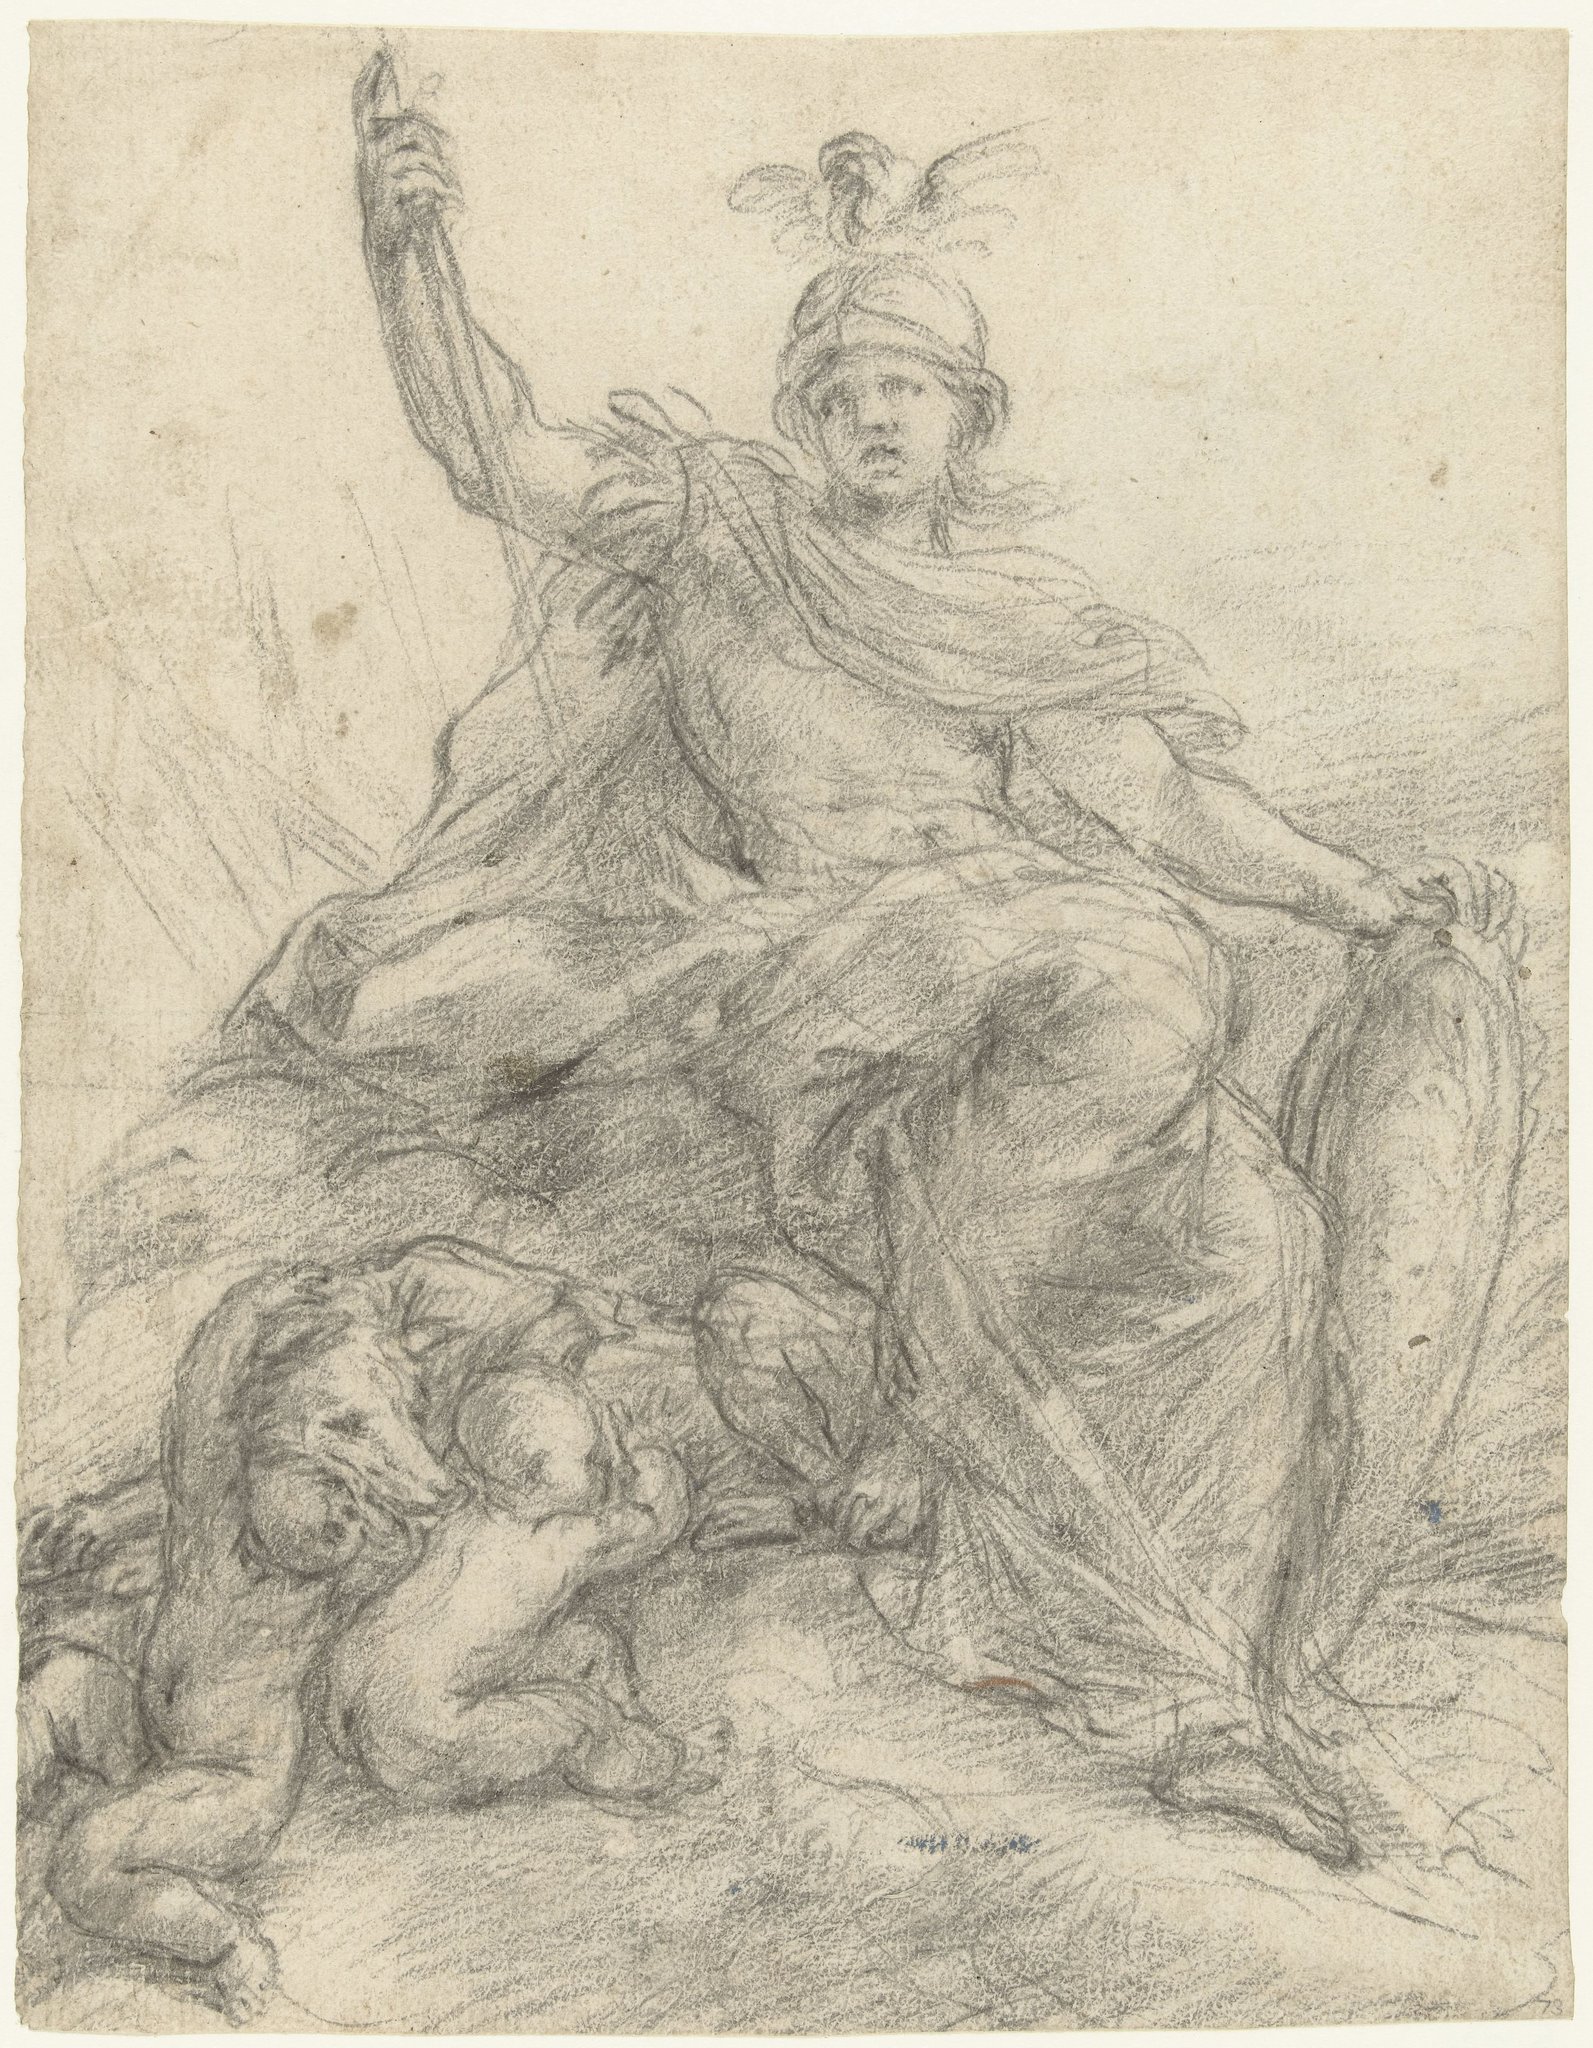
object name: drawing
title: Minerva as Rome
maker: alessandro algardi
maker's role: draughtsman, sculptor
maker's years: 1598-1654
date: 1640-1650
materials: chalk, paper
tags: (story of) minerva (pallas, athena)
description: The sculptor Algardi mainly drew in preparation for his (portrait) sculptures and reliefs. In the case of this drawing, however, no sculpture is known. It is therefore quite possible that this sheet served as a design for a print. The goddess Minerva, recognizable by her helmet, personifies Rome here. Depicted at her feet are the city’s founders Romulus and Remus being suckled by a wolf.